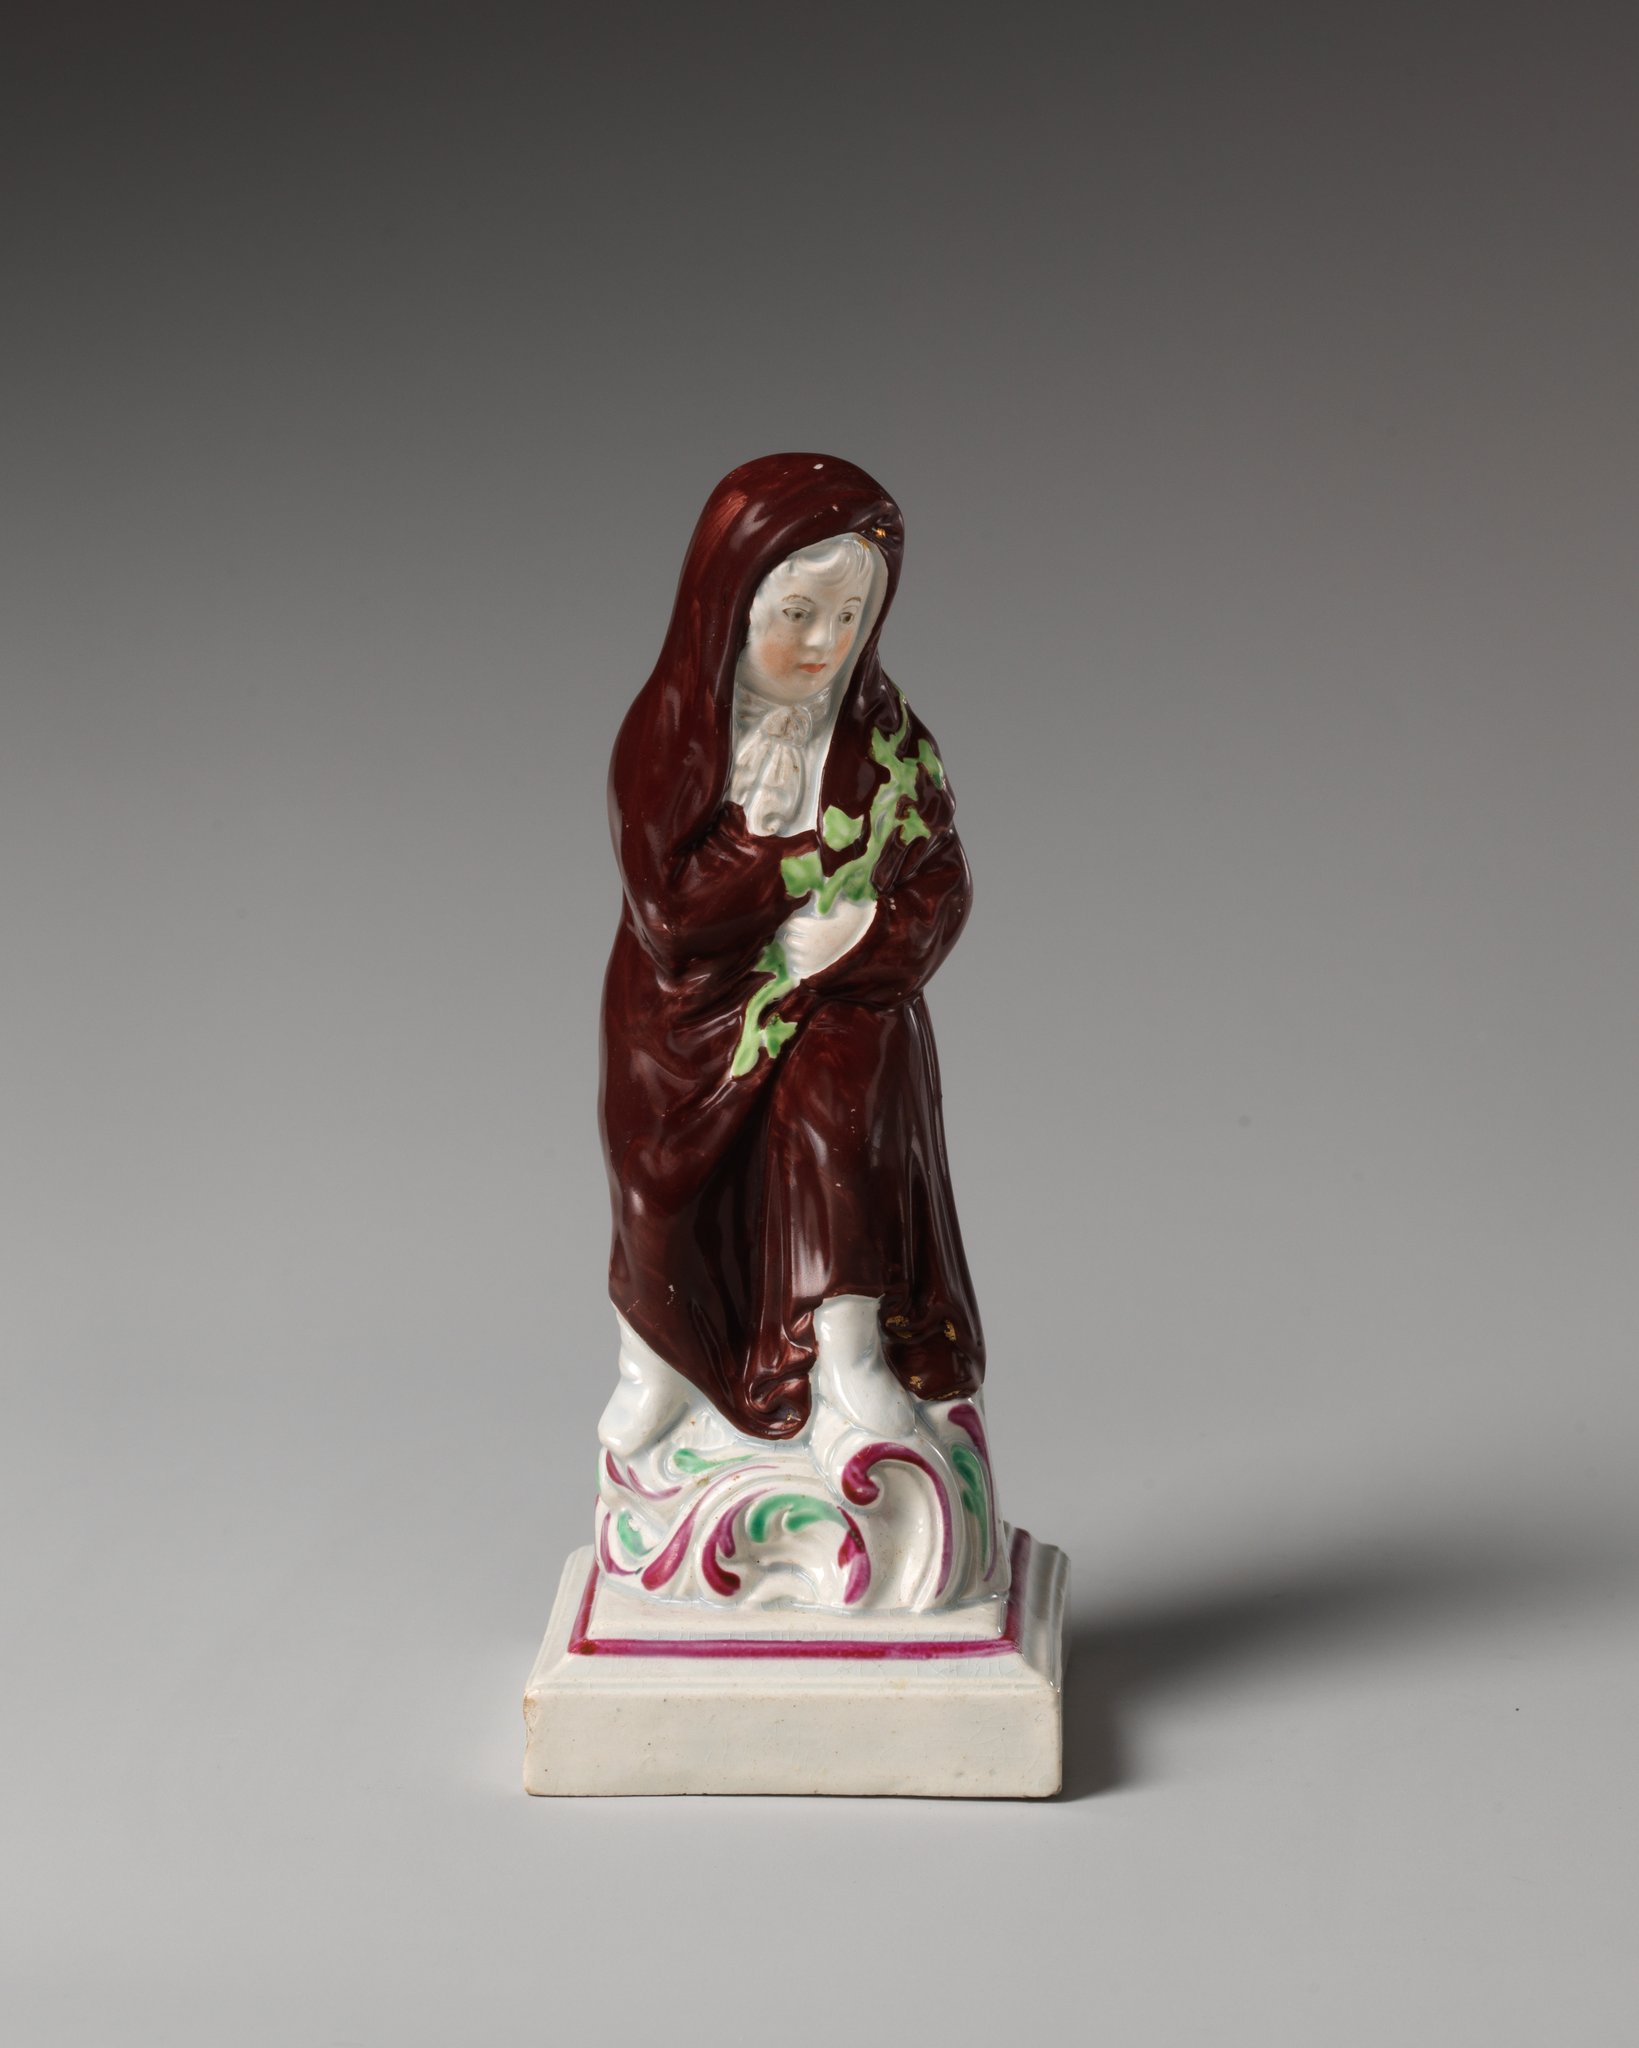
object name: figure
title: Winter (part of a set of four)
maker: neale & co.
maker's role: maker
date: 1780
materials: earthenware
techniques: enamel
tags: portraits,women,winter